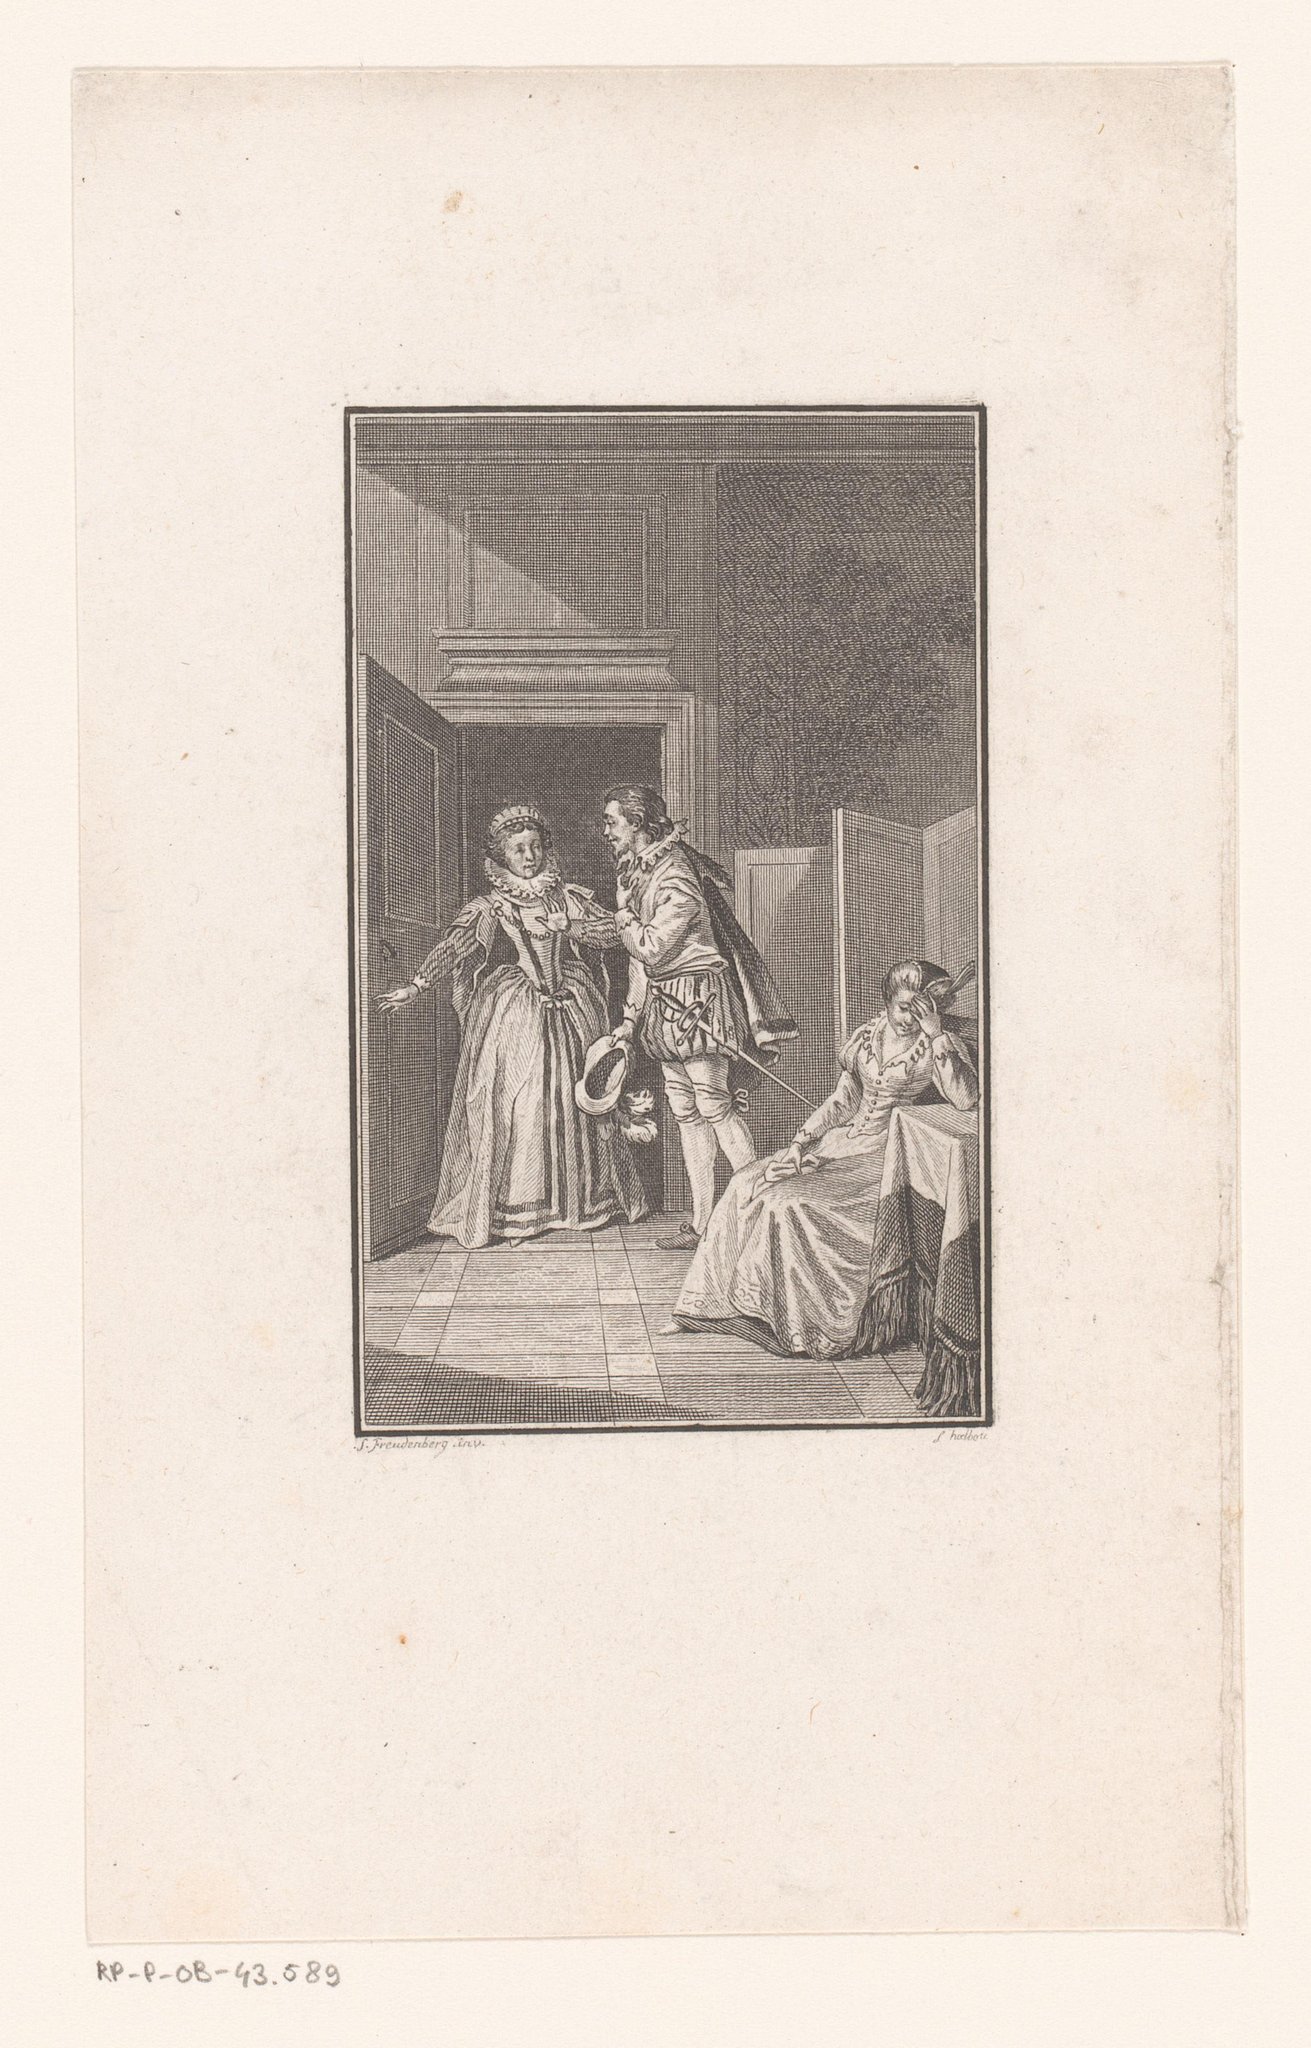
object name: print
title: Interieur met twee vrouwen en een edelman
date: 1781-1782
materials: paper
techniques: etching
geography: bern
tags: nobility and patriciate; chivalry, knighthood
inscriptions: collector's mark: Lugt 2228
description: Interieur met een vrouw staand in een deuropening bij een edelman. Naast hem een vrouw neergezeten op een stoel.